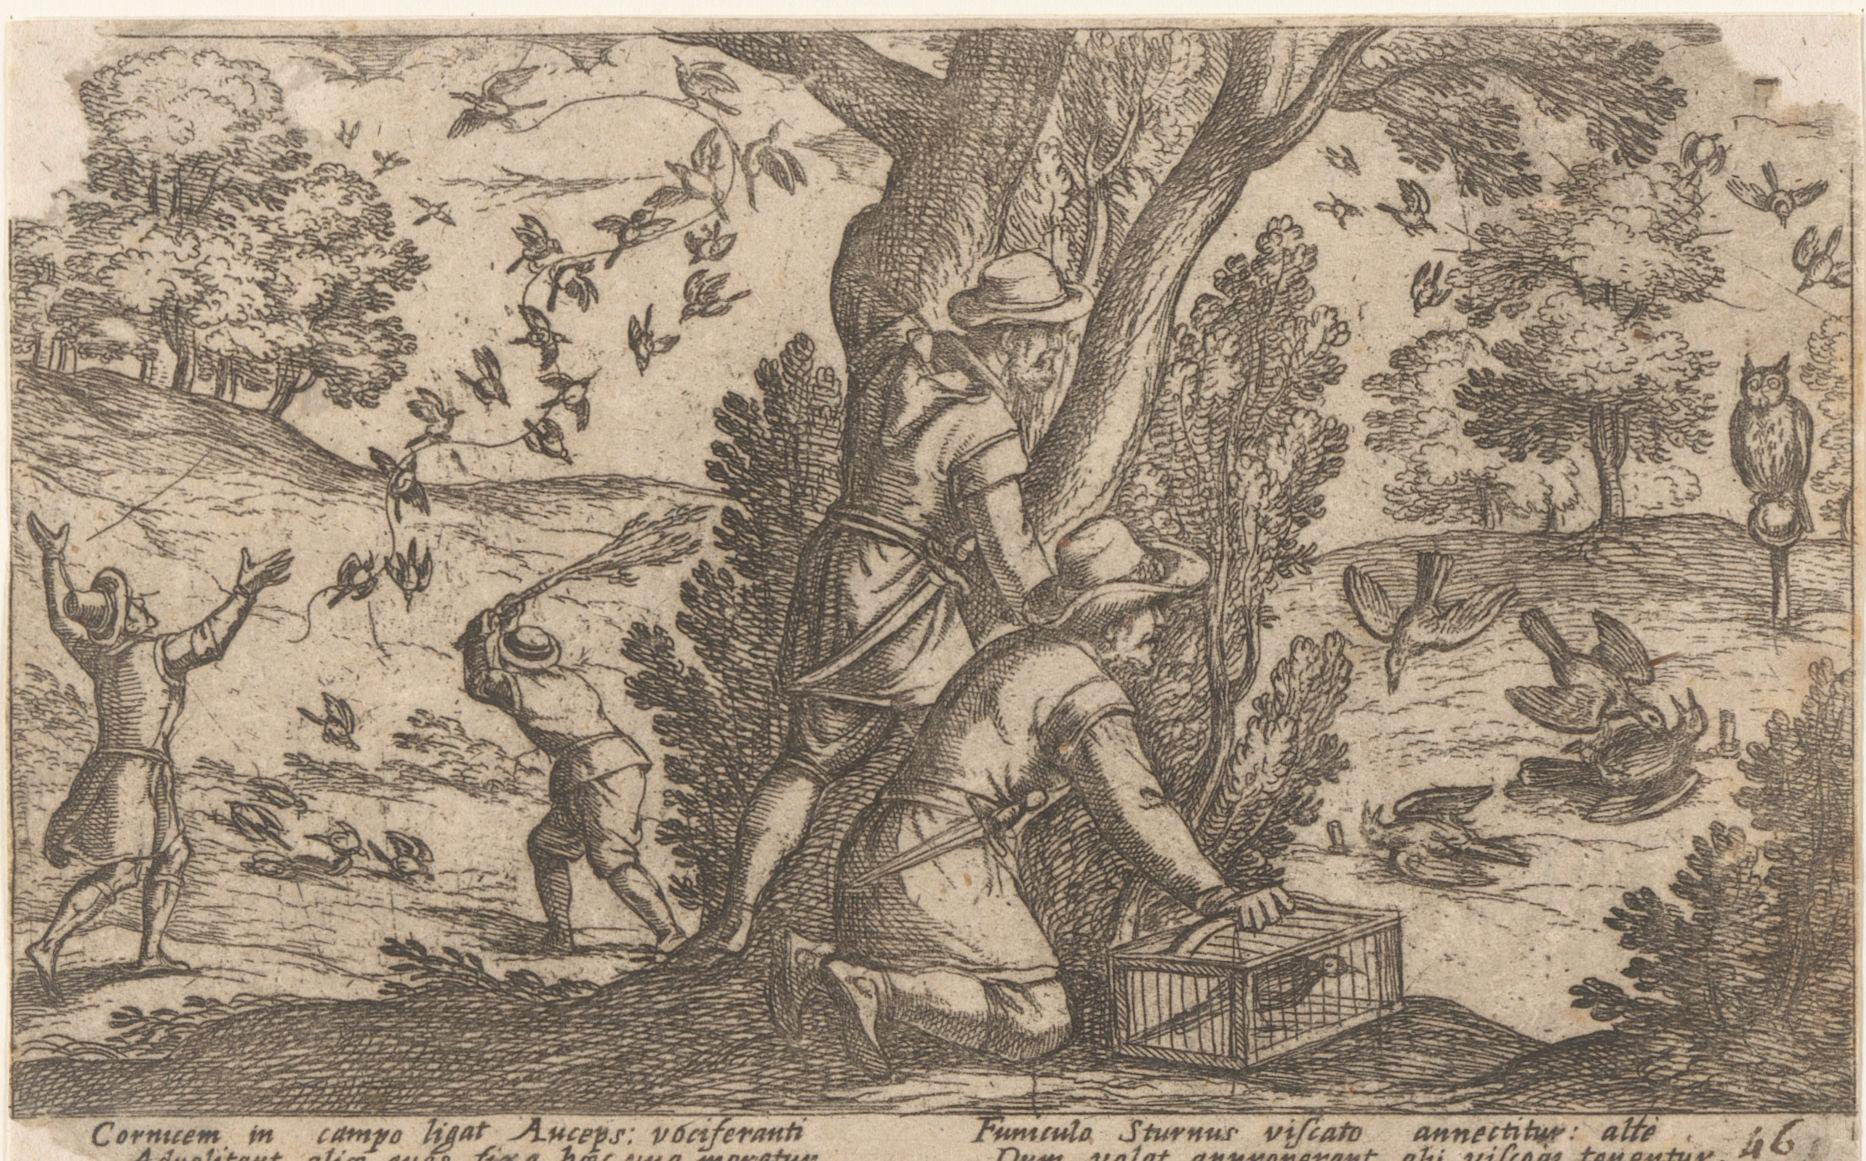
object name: print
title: Diverse jacht- en strijdscènes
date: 1605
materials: paper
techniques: etching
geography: italy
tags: hunter, hunters hunting (n.b.: in 1988-1990 this notation denoted the concept of 43c11421 'hunters resting during the hunt'), bird hunting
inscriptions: number: ‘46’, collector's mark: ‘Hinloopen’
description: Landschap met jagers die vogels proberen te vangen. Op de voorgrond twee jagers verscholen achter een boom. Tekst in het Latijn in ondermarge.